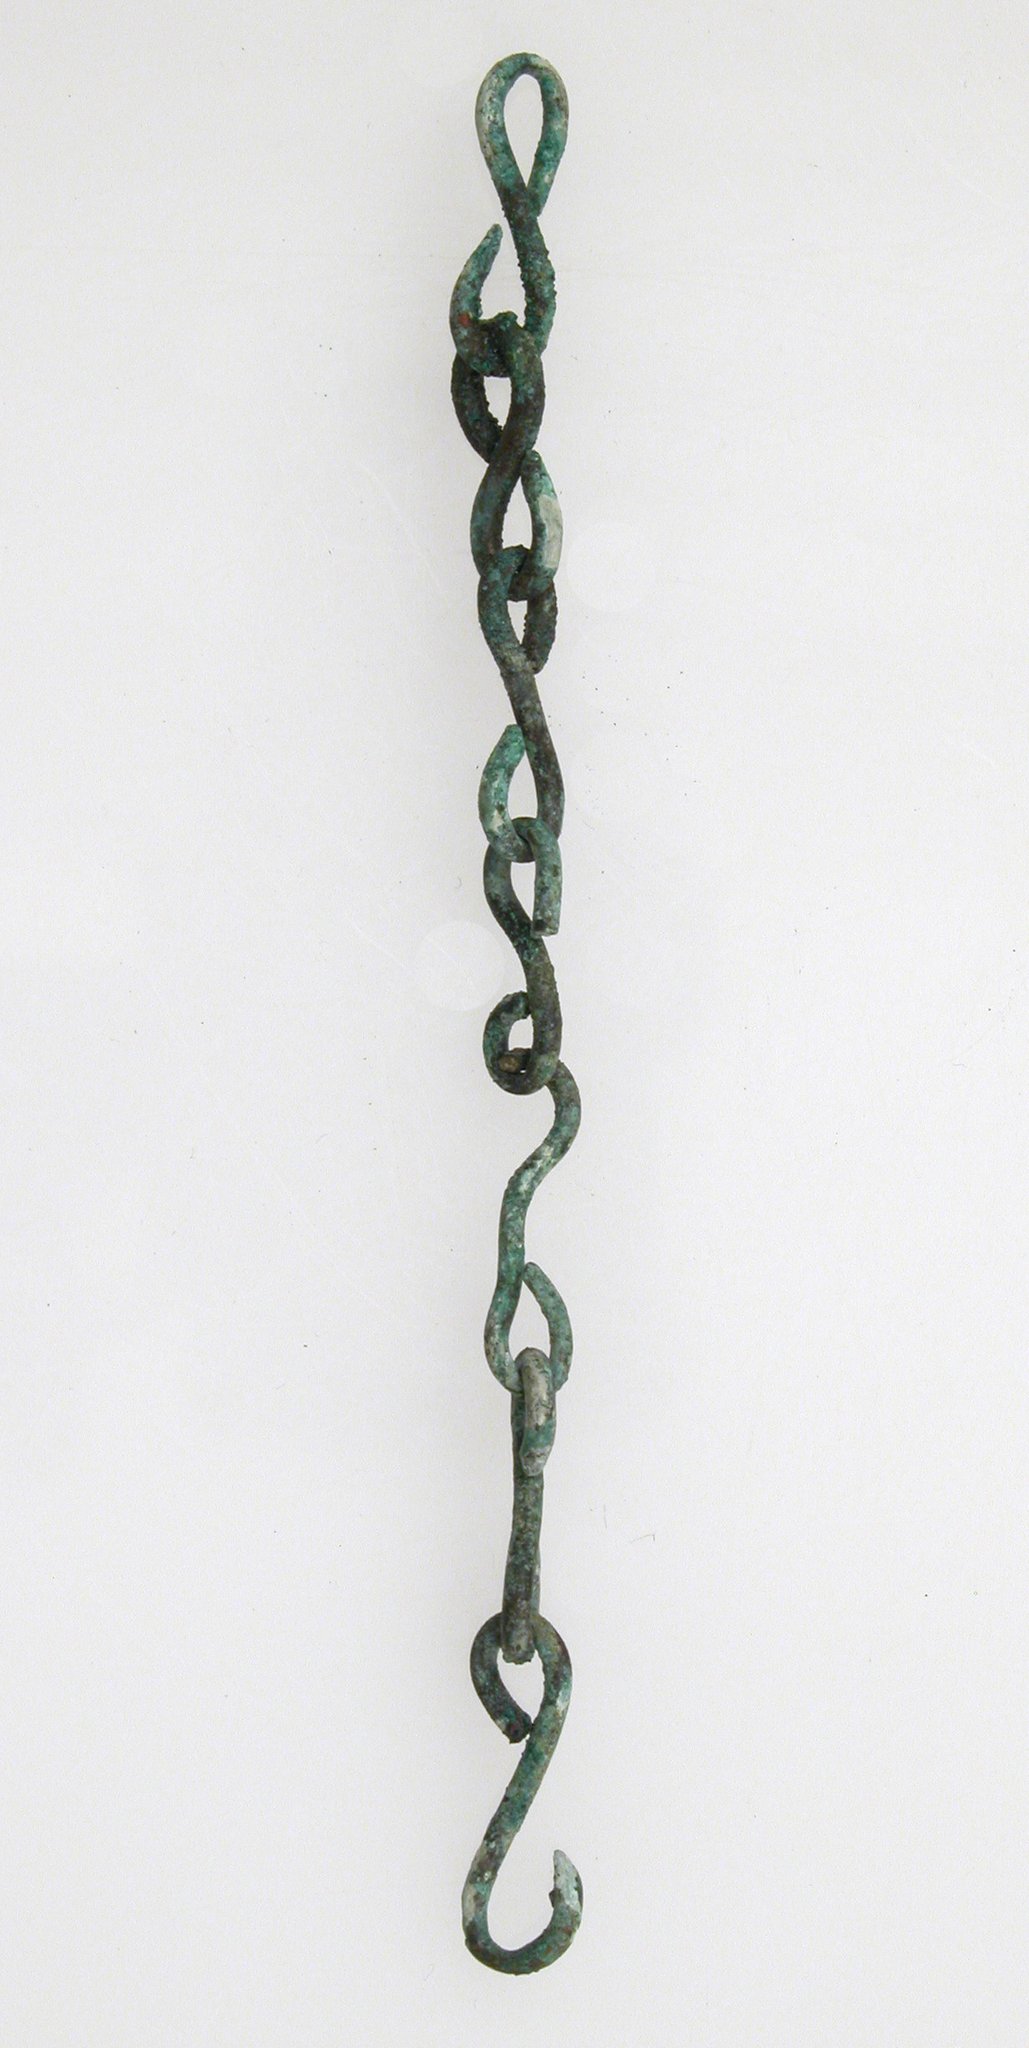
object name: chain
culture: frankish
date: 501-700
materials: copper alloy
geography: germany